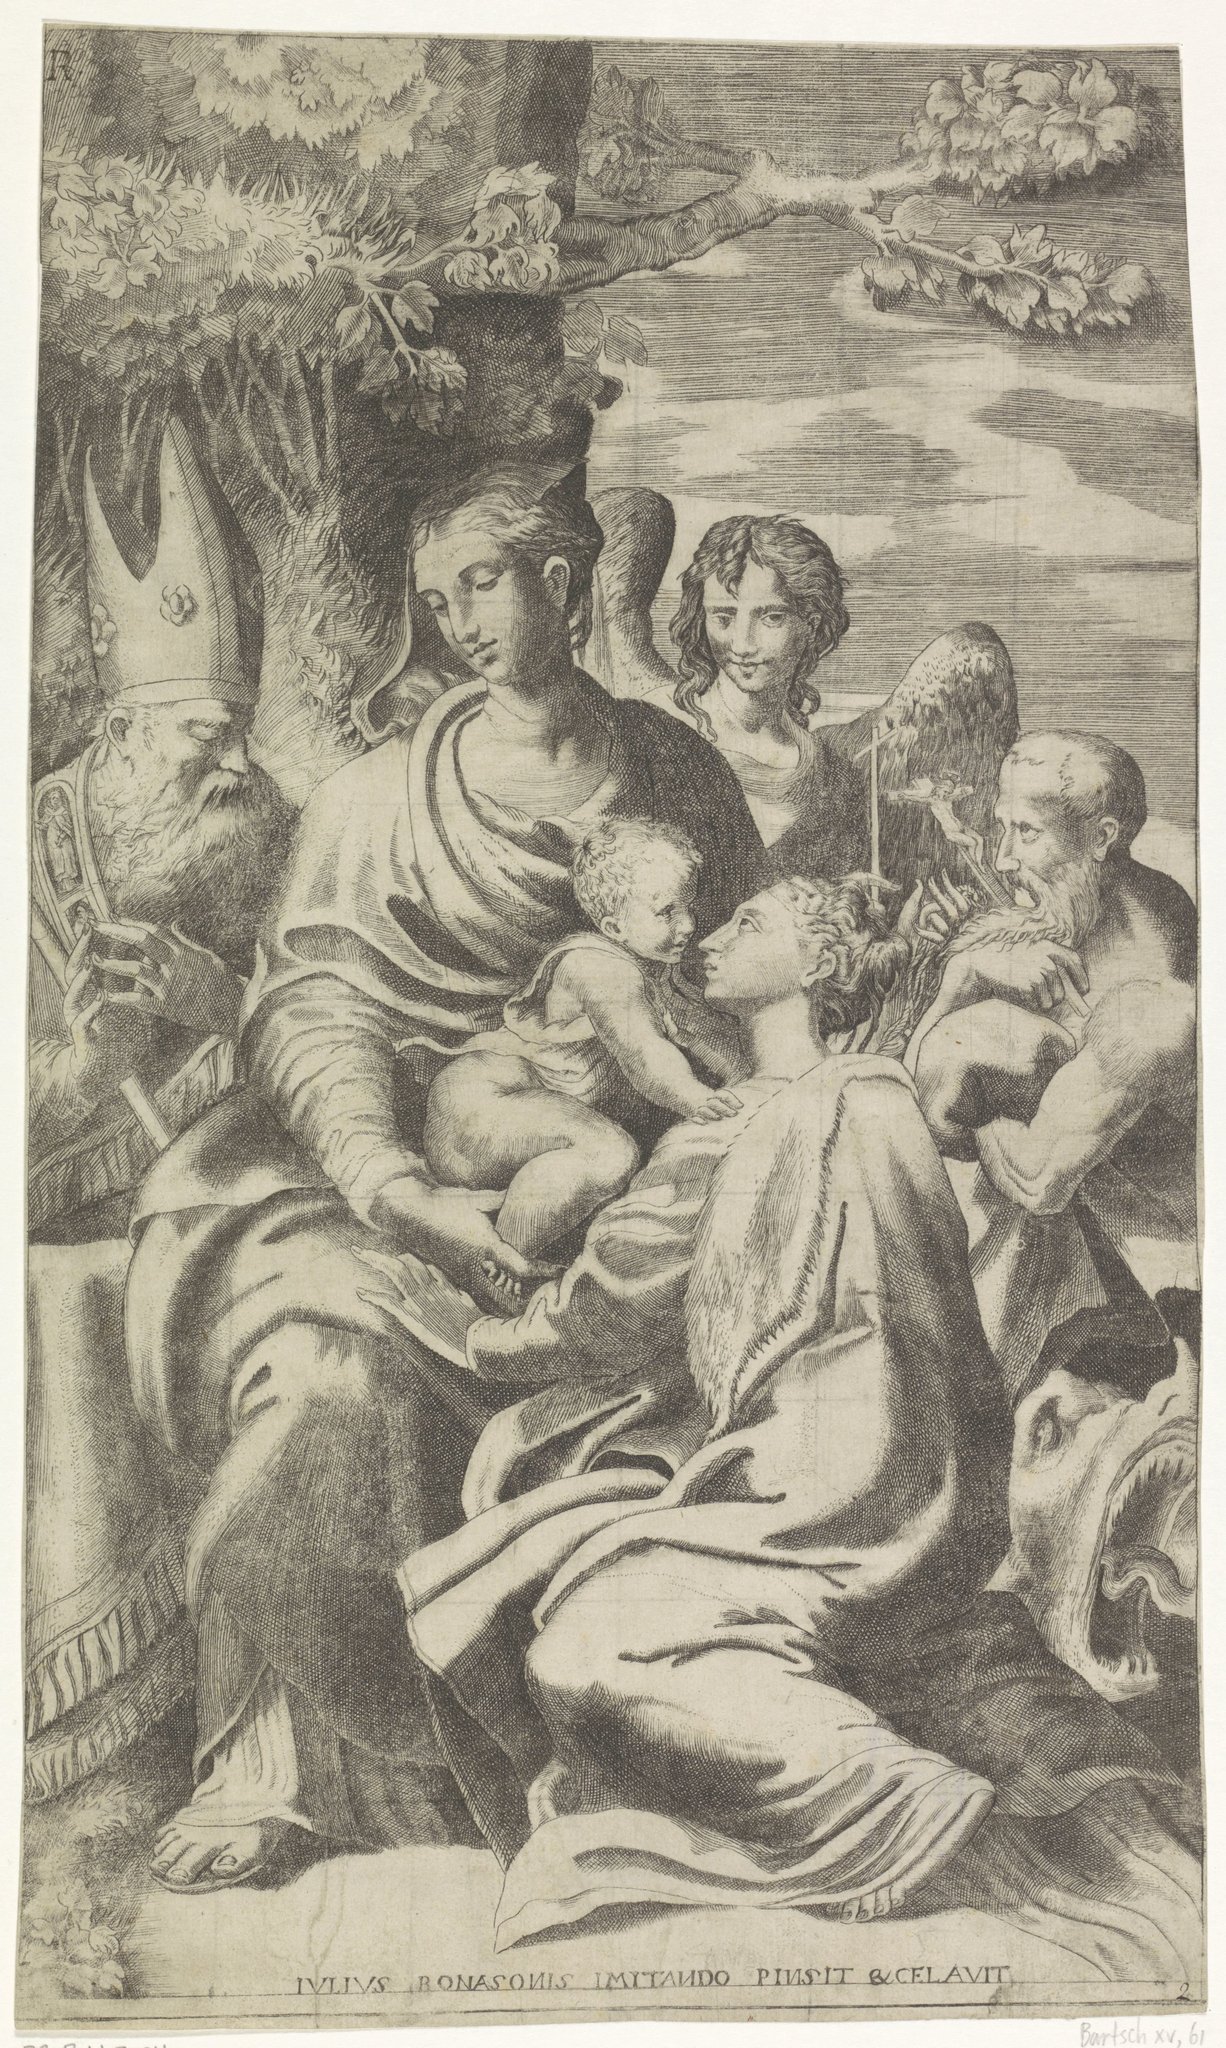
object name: print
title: Maria met het Christuskind en heiligen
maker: giulio bonasone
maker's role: painter, print maker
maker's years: 1510-1576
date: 1501-1580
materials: paper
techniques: engraving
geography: italy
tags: benedict of nurcia, abbot of monte cassino and founder of the benedictine order; possible attributes: aspergillum, book, cup (sometimes broken), raven with loaf, sieve (or tray), madonna: i.e. mary with the christ-child, madonna accompanied by saint(s), the virgin martyr margaret of antioch; possible attributes: cross, crown, dragon (under feet or on chain), (chaplet of) pearls, the monk and hermit jerome (hieronymus); possible attributes: book, cardinal's hat, crucifix, hour-glass, lion, skull, stone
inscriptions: collector's mark: ‘R’, number: ‘2’, collector's mark: Lugt 11, collector's mark: Lugt 10, collector's mark: ‘Hinloopen’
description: Maria zit met het Christuskind op schoot. Voor haar knielt Margareta van Antiochië met naast haar een draak. Achter Maria staan de heilige Benedictus, een engel en de heilige Hieronymus.